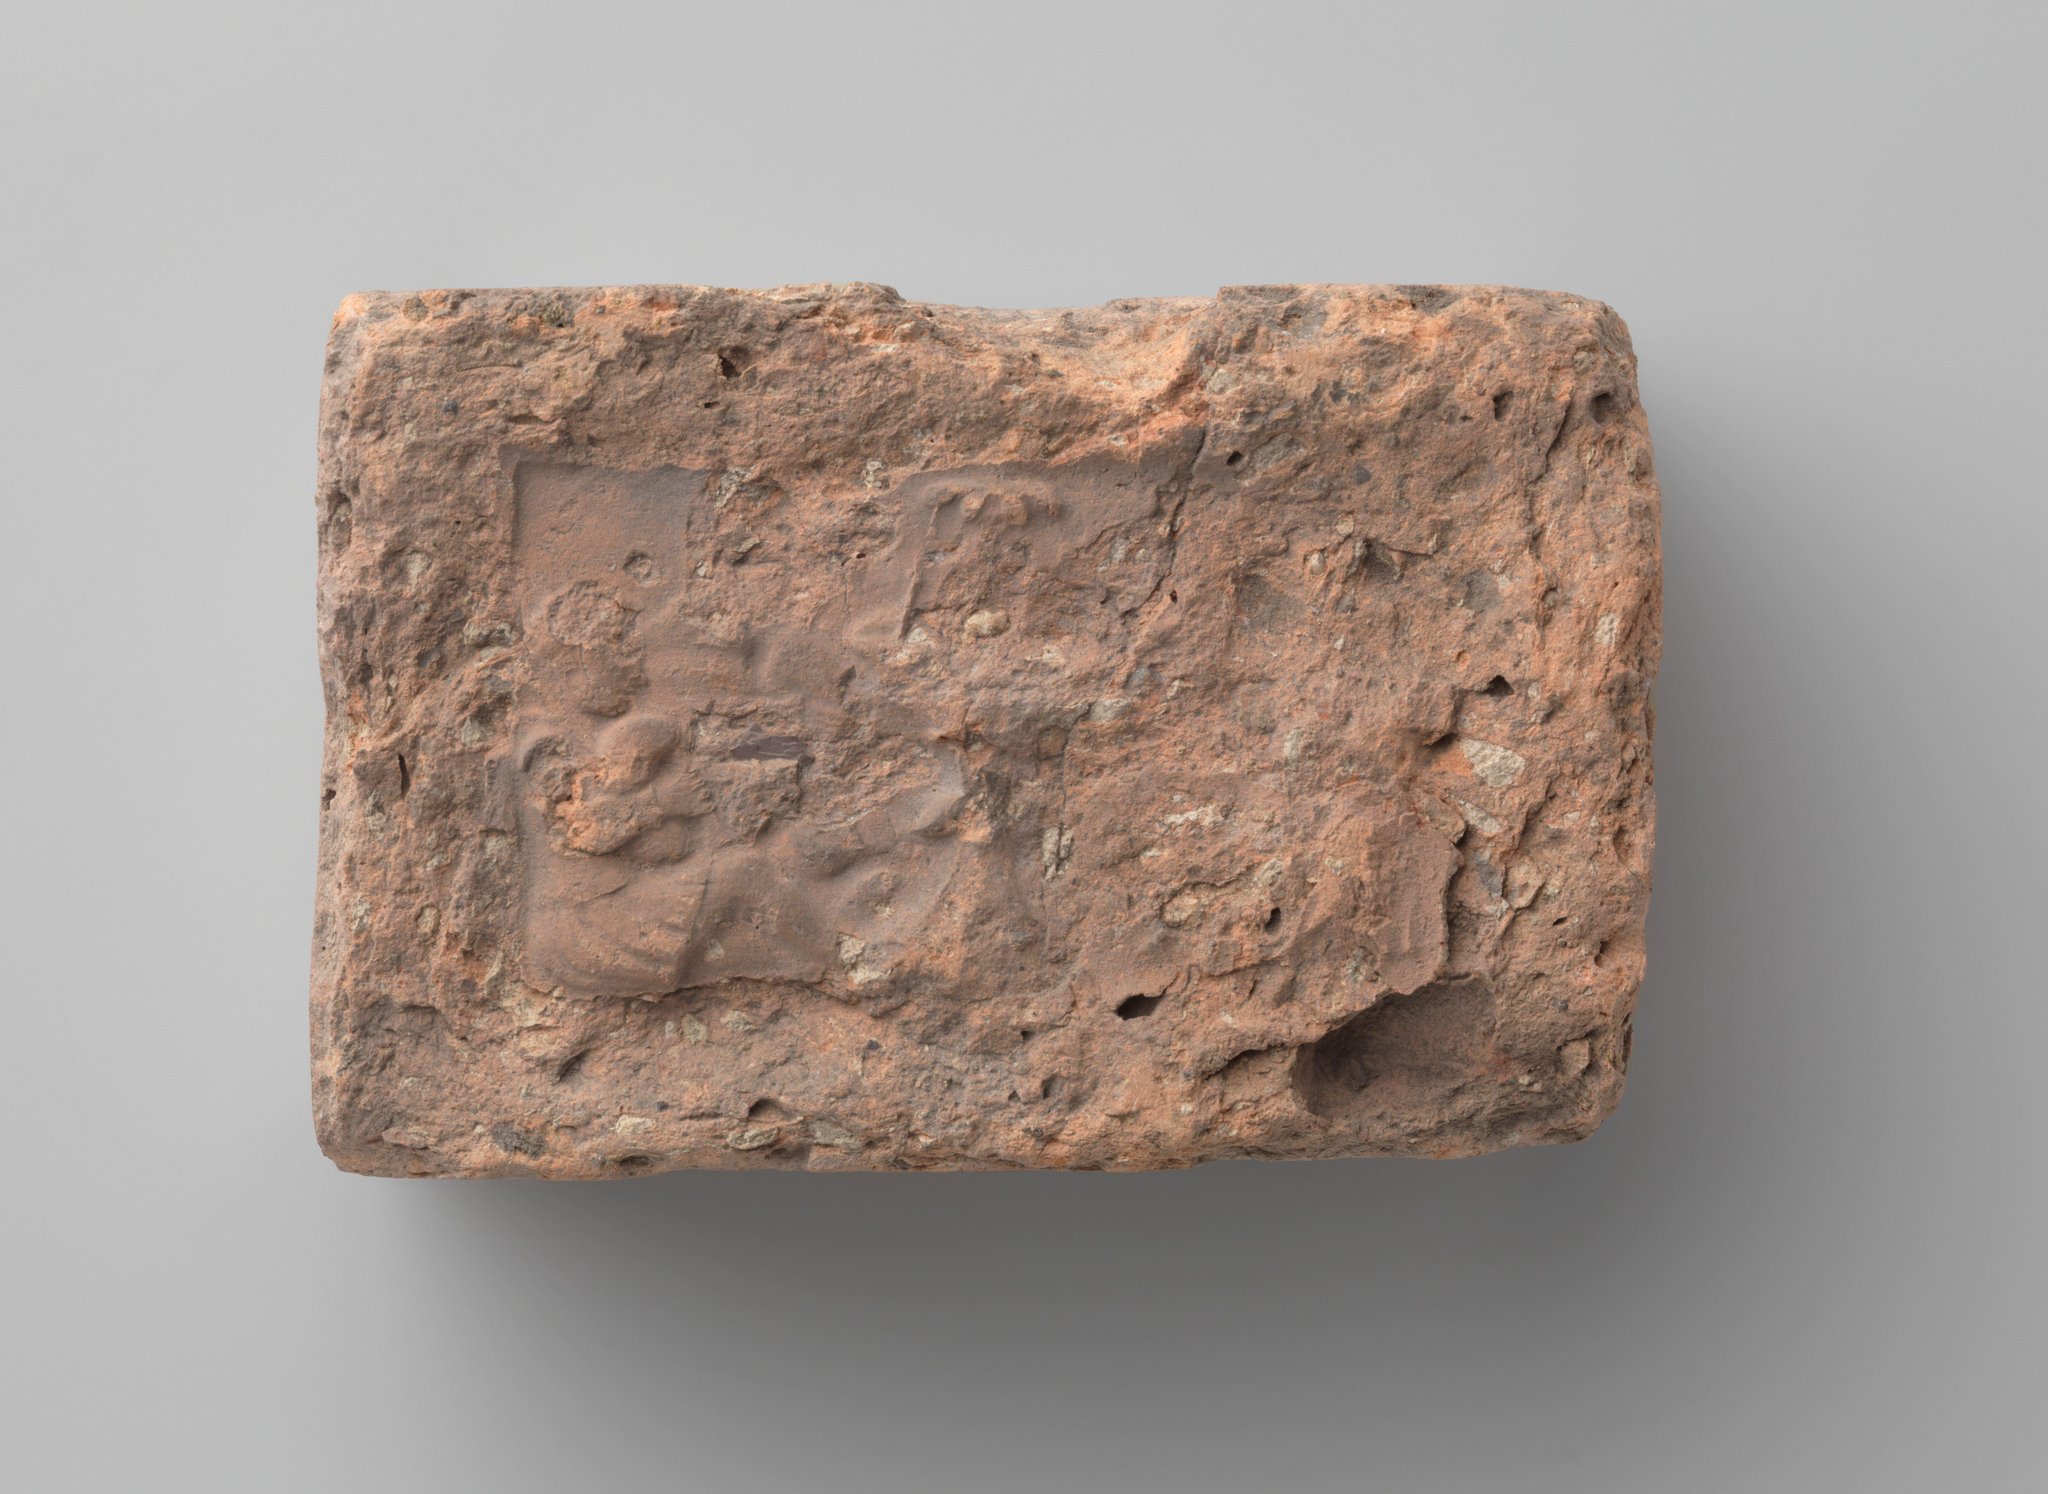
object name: hearthstone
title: Haardsteen met pastorale scène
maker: Anonymous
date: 1550-1575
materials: earthenware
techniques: printing, firing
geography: southern netherlands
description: Haardsteen met pastorale scène. Op de voorgrond twee herders (waarvan er een op een doedelzak speelt) aan weerszijden van een fontein; op de heuvelachtige achtergrond een kudde schapen, enkele bomen en een tempel.